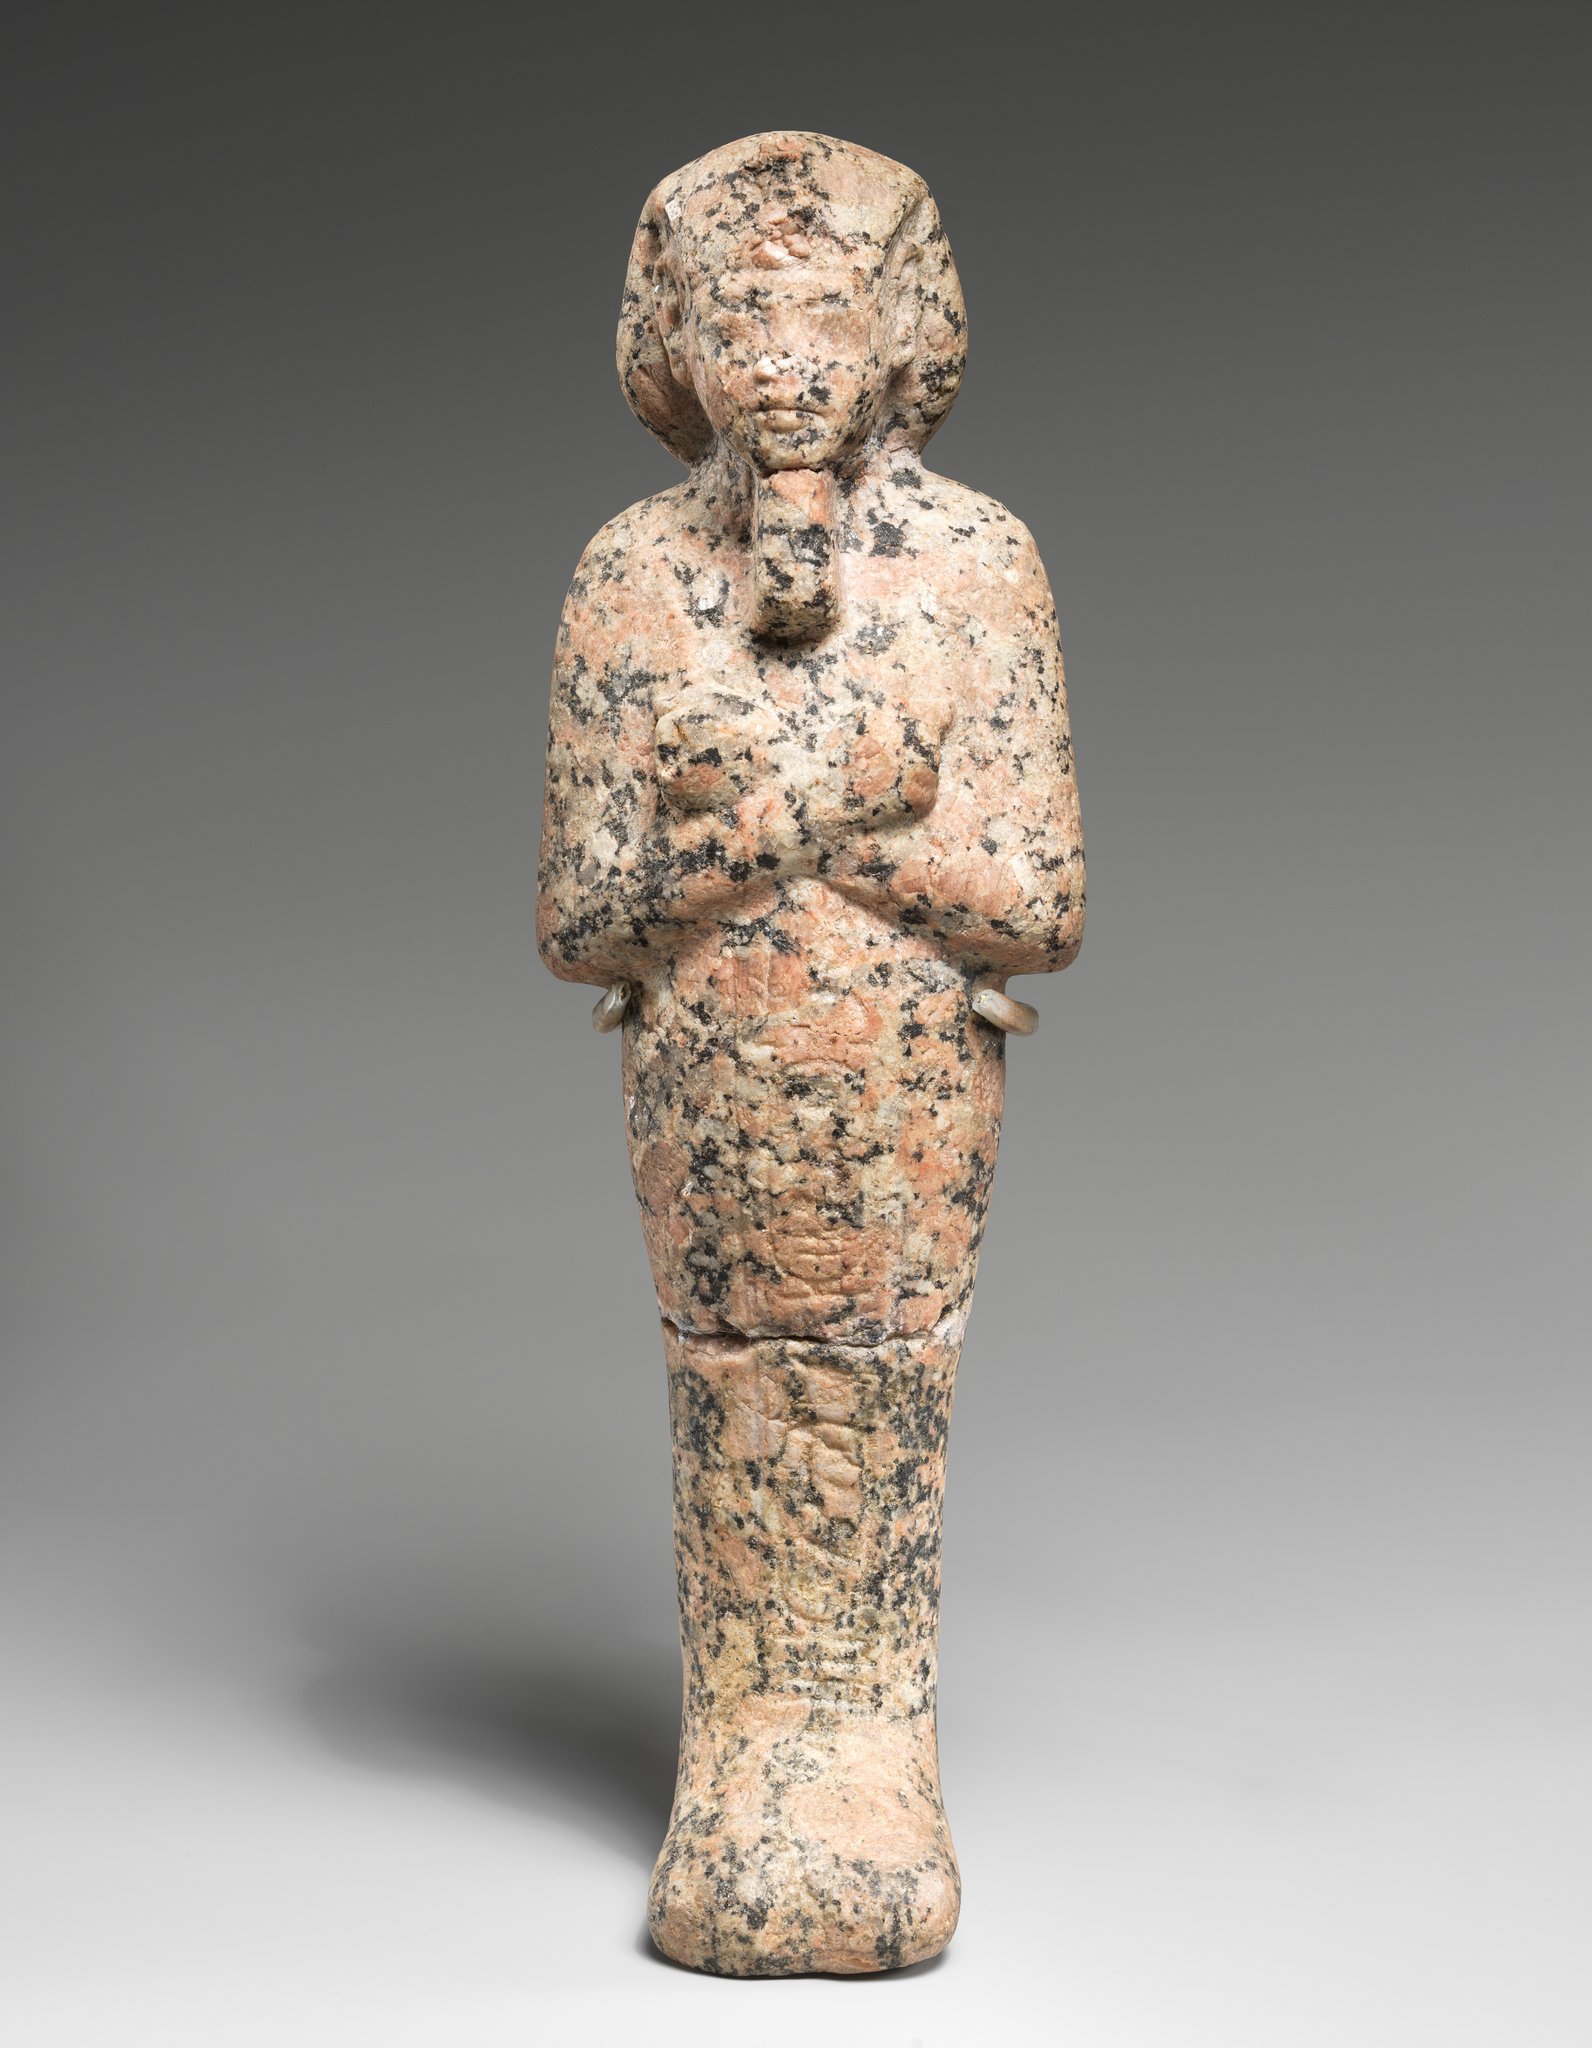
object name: funerary figure, shabti, akhenaten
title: Funerary Figure of Akhenaten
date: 1353-1336 BCE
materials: granite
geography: middle egypt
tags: men